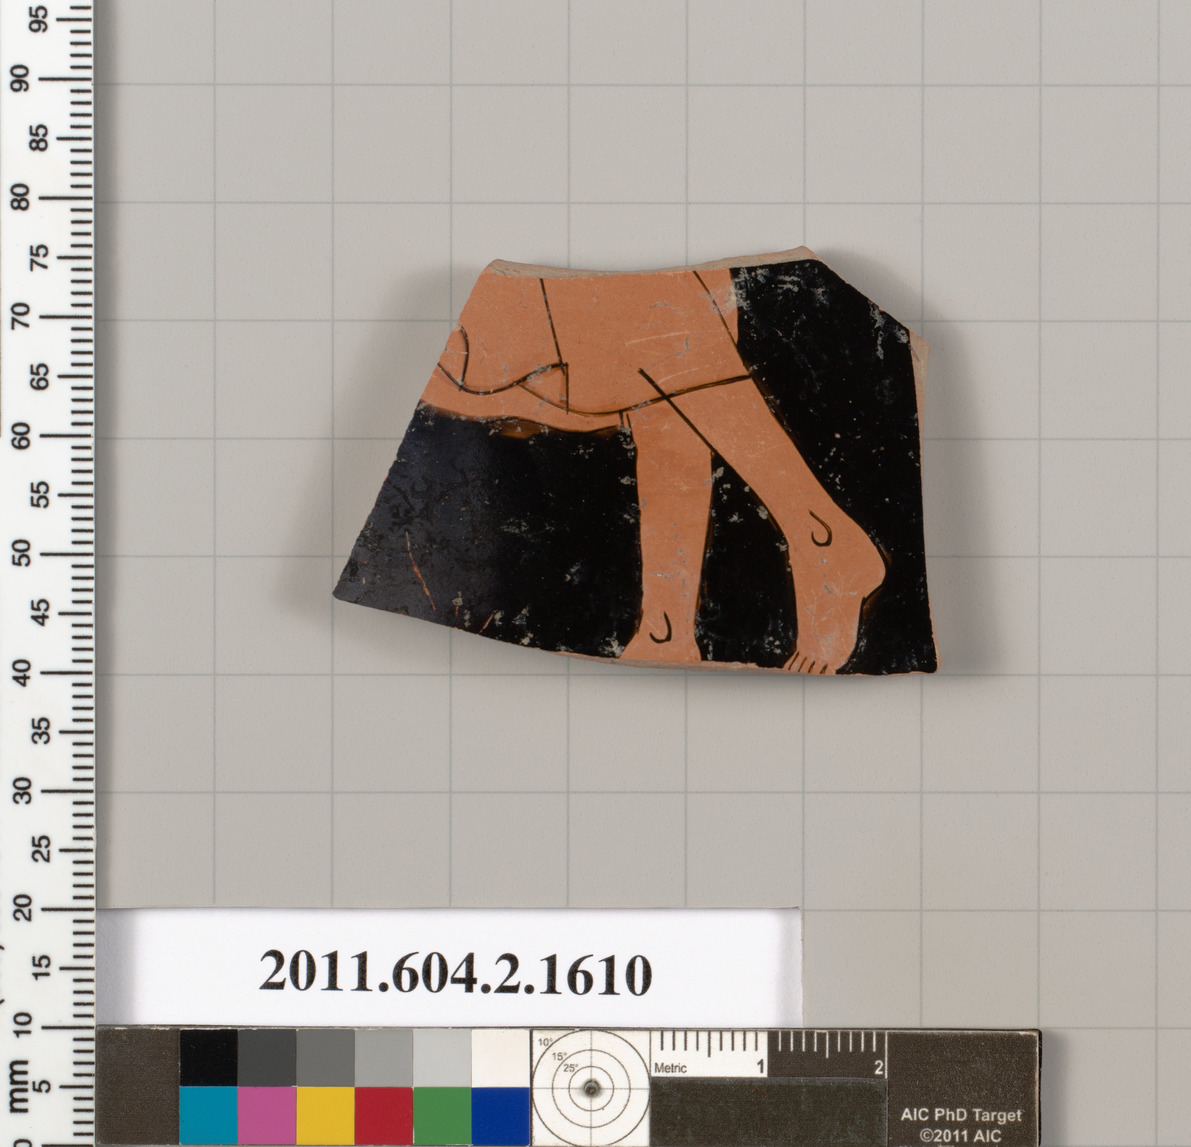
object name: skyphos fragment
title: Terracotta fragment of a skyphos (deep drinking cup)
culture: greek, attic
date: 480-470 BCE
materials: terracotta